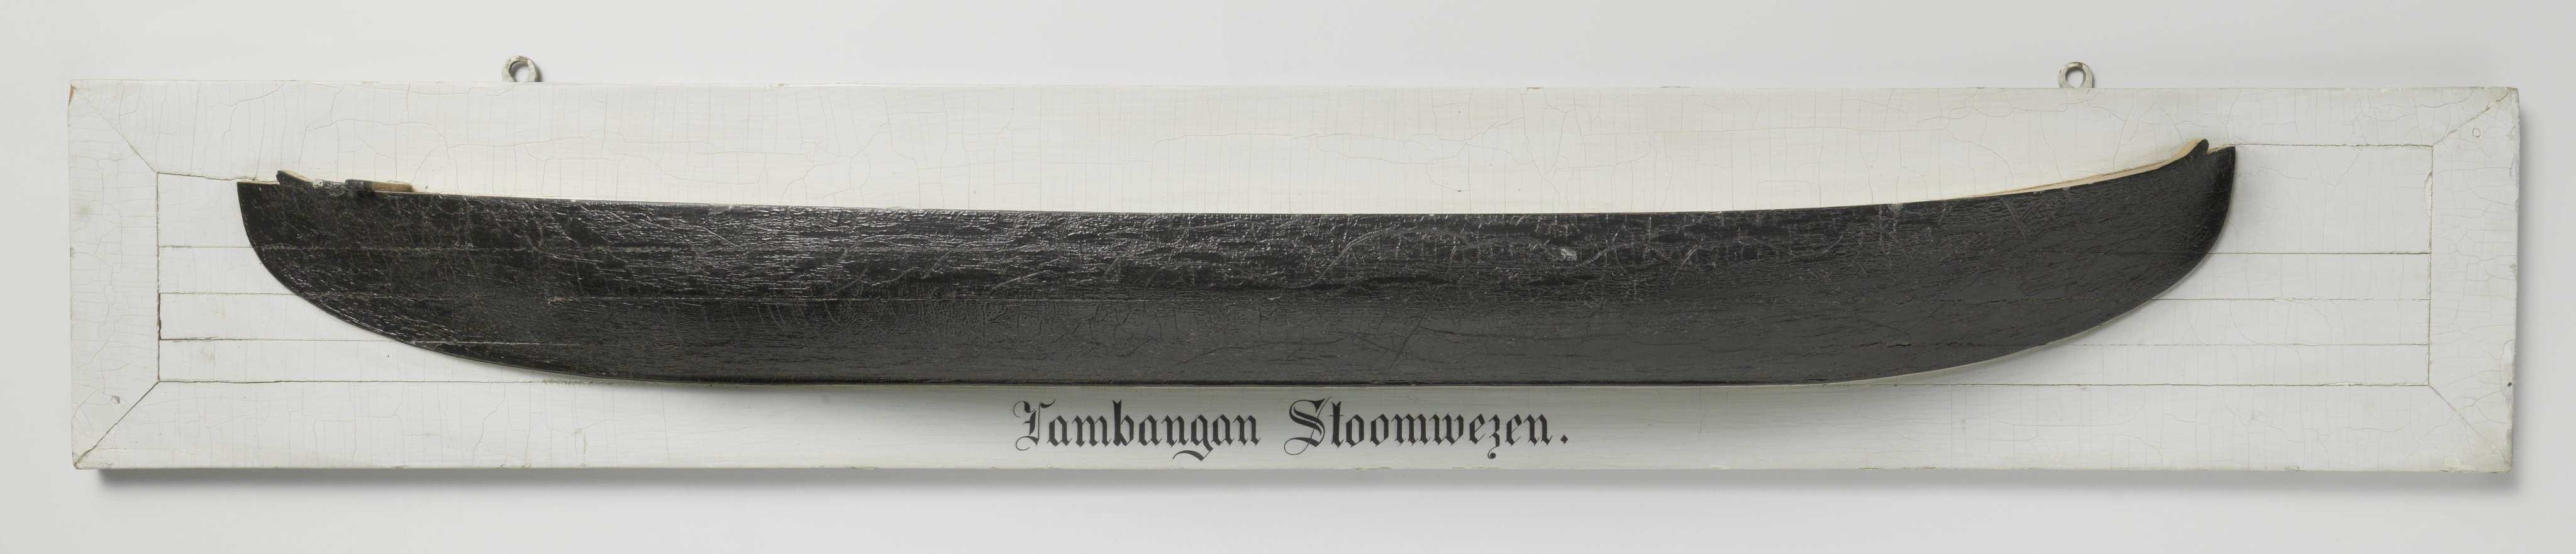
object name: ship model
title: Half Model of a Tambangan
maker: Anonymous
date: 1860-1880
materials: wood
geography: indonesian archipelago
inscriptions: inscription, bottom centre, in a Gothic hand: ‘Tambangan Stoomwezen.’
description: Een tambangan is een klein roeivaartuigje bestemd voor het vervoeren van passagiers. Deze tambangan werd blijkens het opschrift voor de Dienst Stoomwezen in Oost-Indië gebouwd. Er is geen verdere informatie over het model bekend.